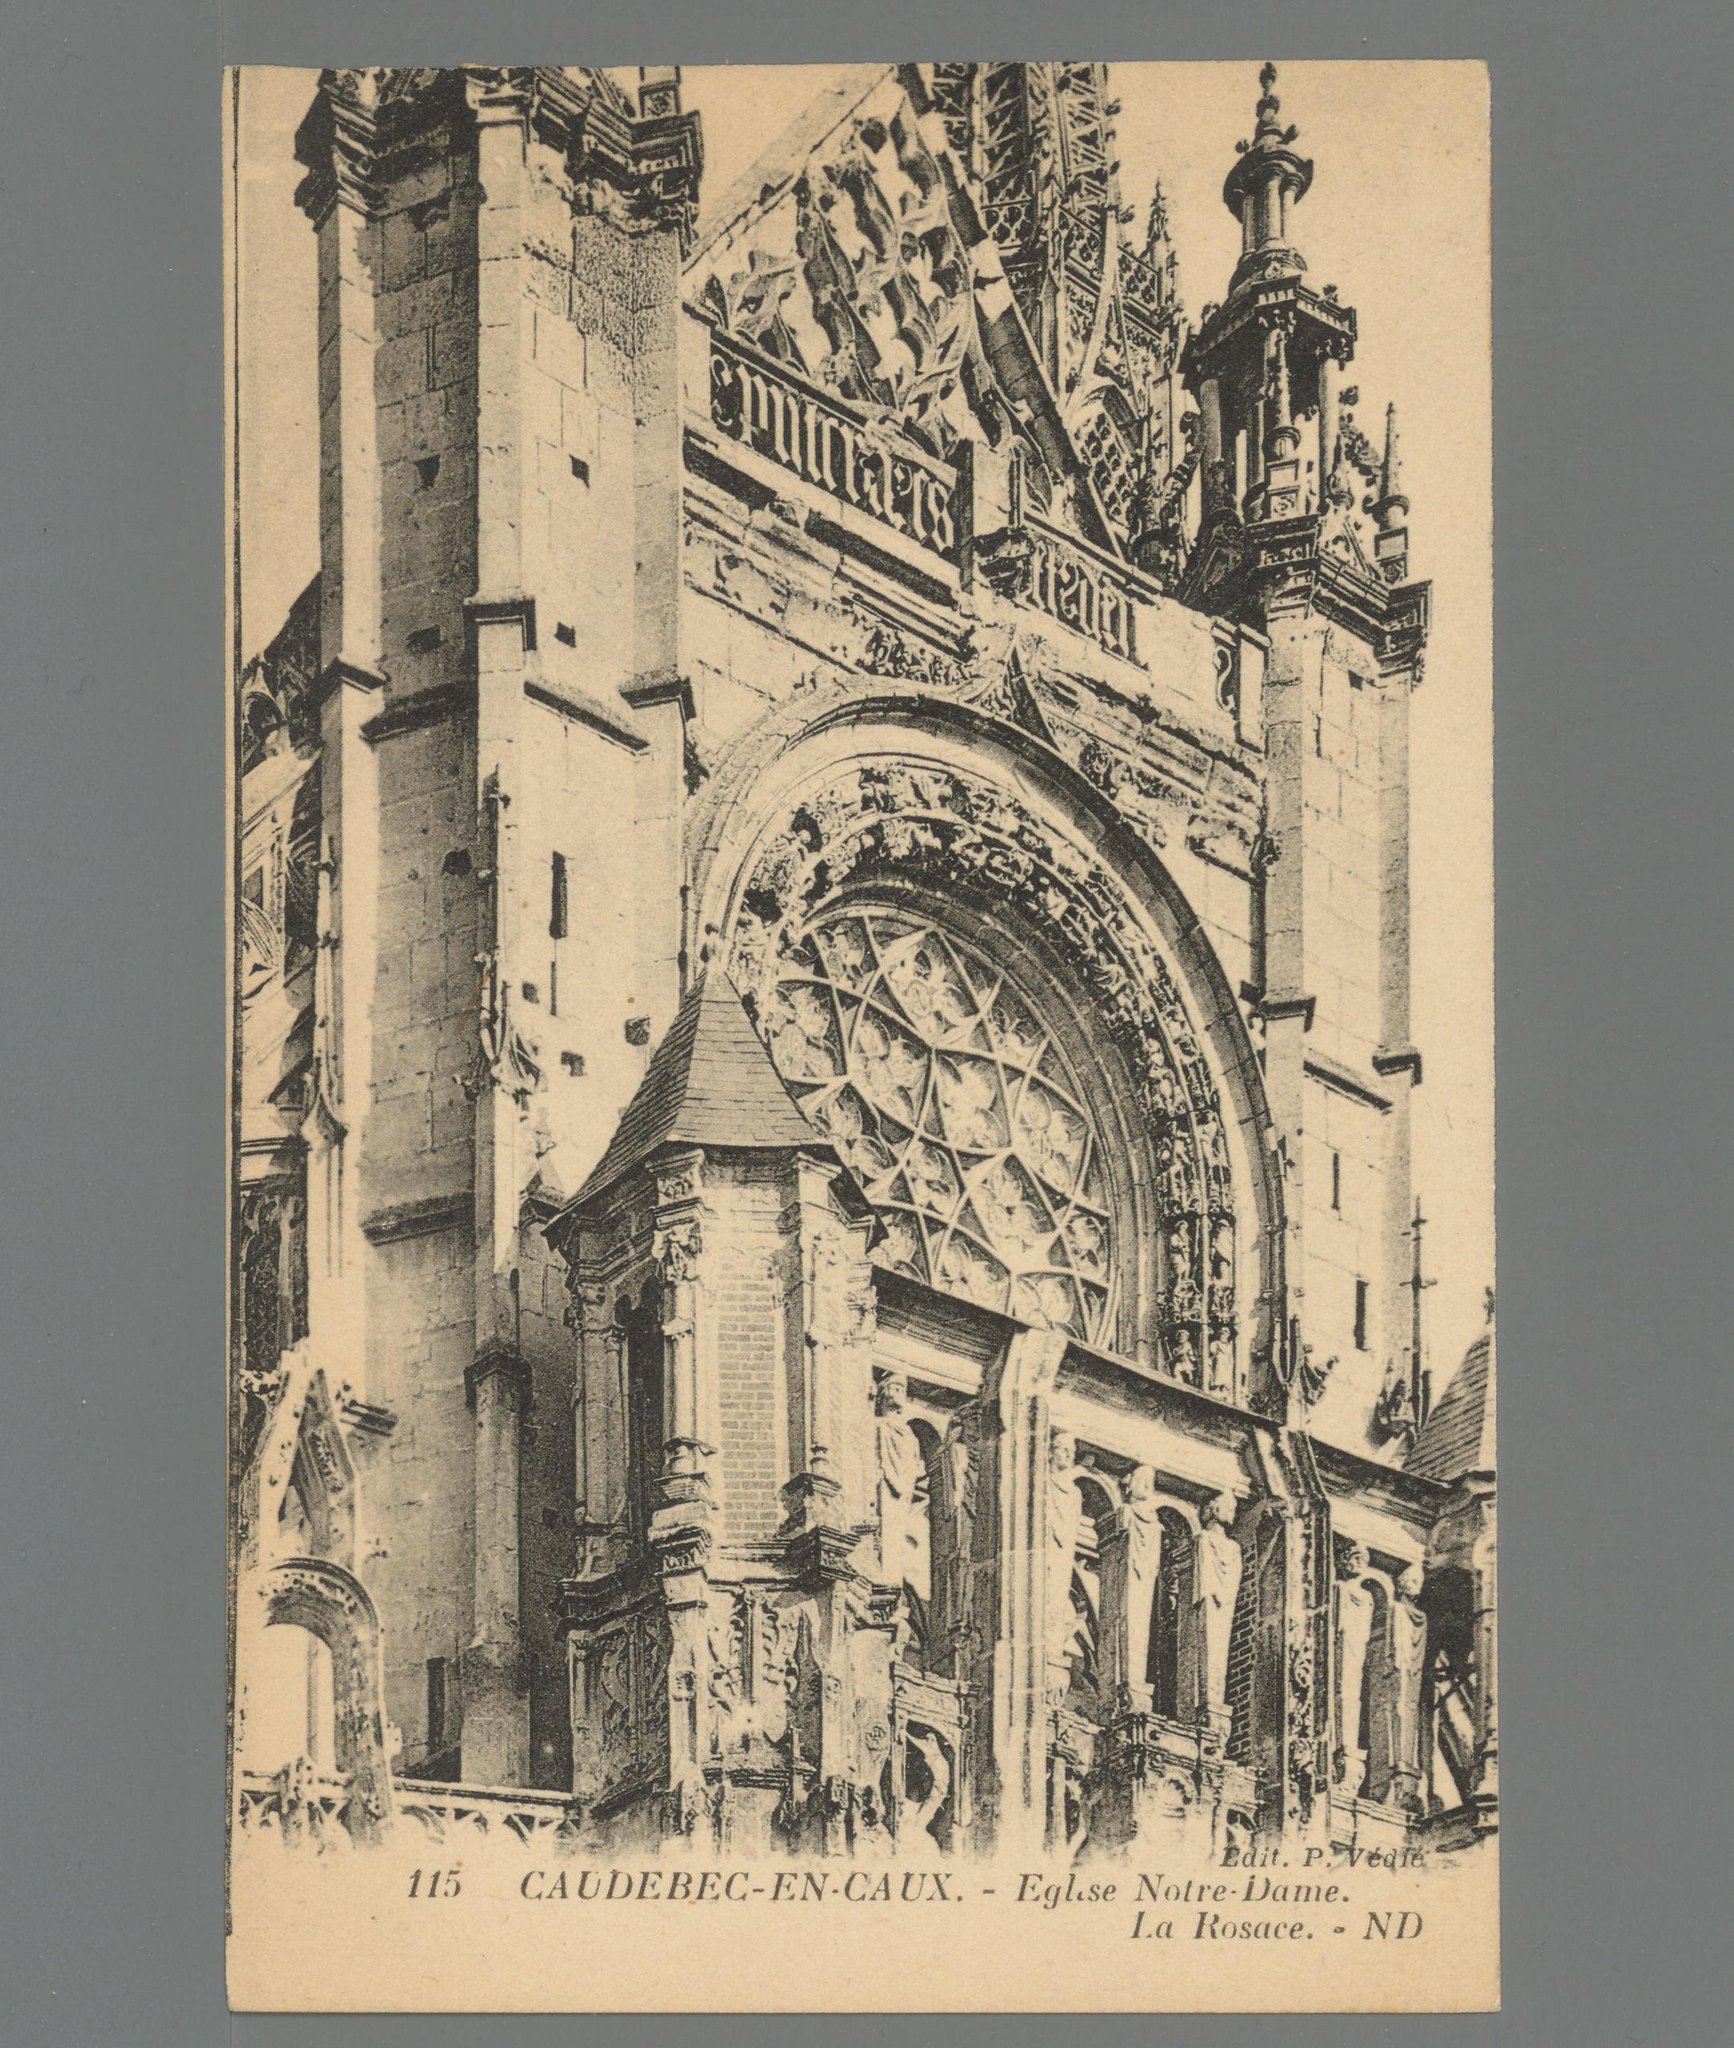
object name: ansichtkaart, prentbriefkaart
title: Caudebec-en Caux. Eglise Notre-Dame. La Rosace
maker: p. védie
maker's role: publisher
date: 1920-1932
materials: cardboard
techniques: photograph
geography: paris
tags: church-window, e.g. rose-window, church (exterior)